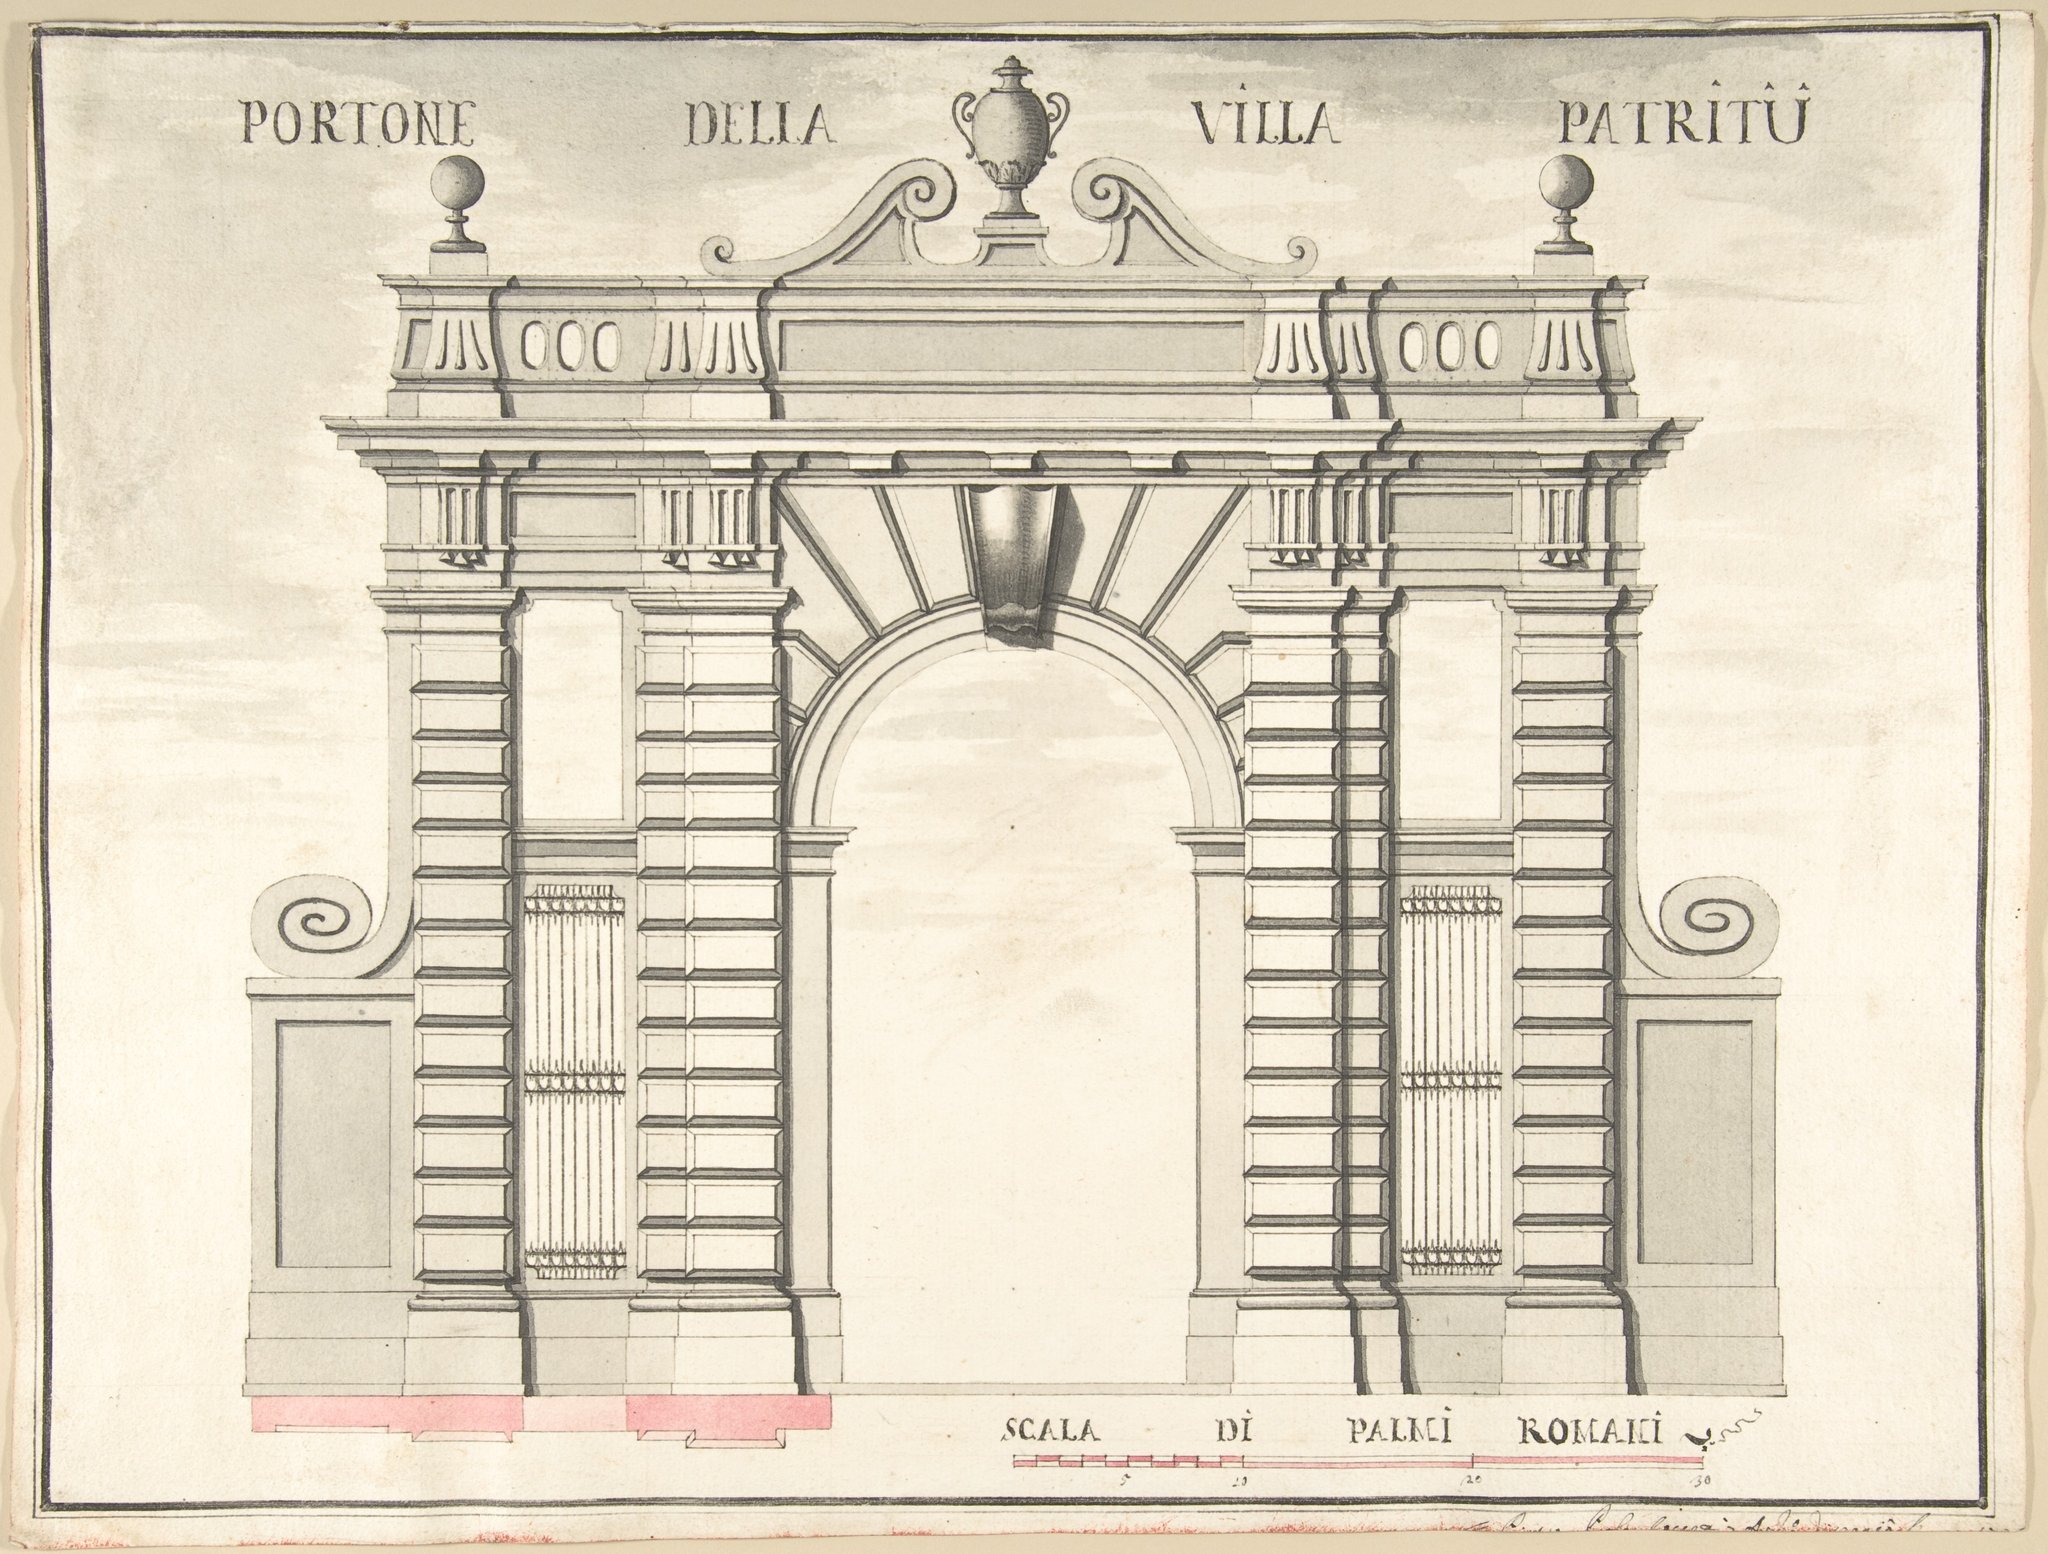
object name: drawing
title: Gate of the Villa Patritii [Patritj]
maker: pietro paolo coccetti (cocchetti)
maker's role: artist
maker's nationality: italian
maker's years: 1710-1727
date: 1710-1727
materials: graphite, ink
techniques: brush, pen, wash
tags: architecture,gates